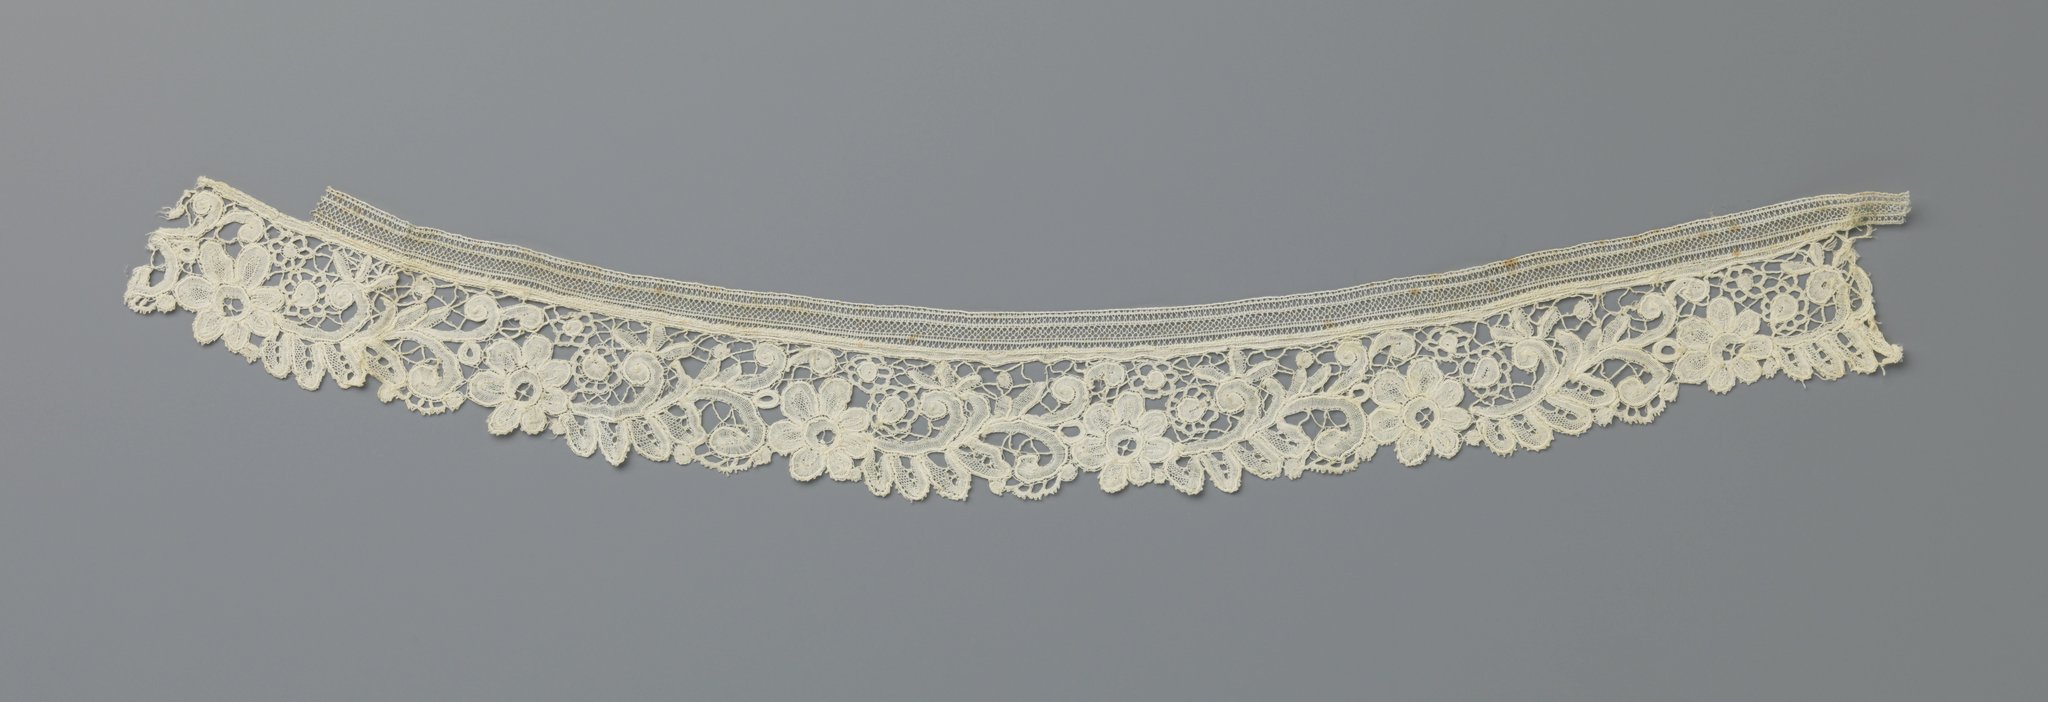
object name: strip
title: Strook kloskant met voluutranken en rozetjes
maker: Anonymous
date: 1875-1899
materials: linen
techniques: lace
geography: netherlands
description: Strook naturelkleurige kloskant: duchesse-kant. Op een vlechtengrond staat een lopend patroon van vertakte voluutranken met ingesneden bladeren en rozetjes, die de schulpen vormen.